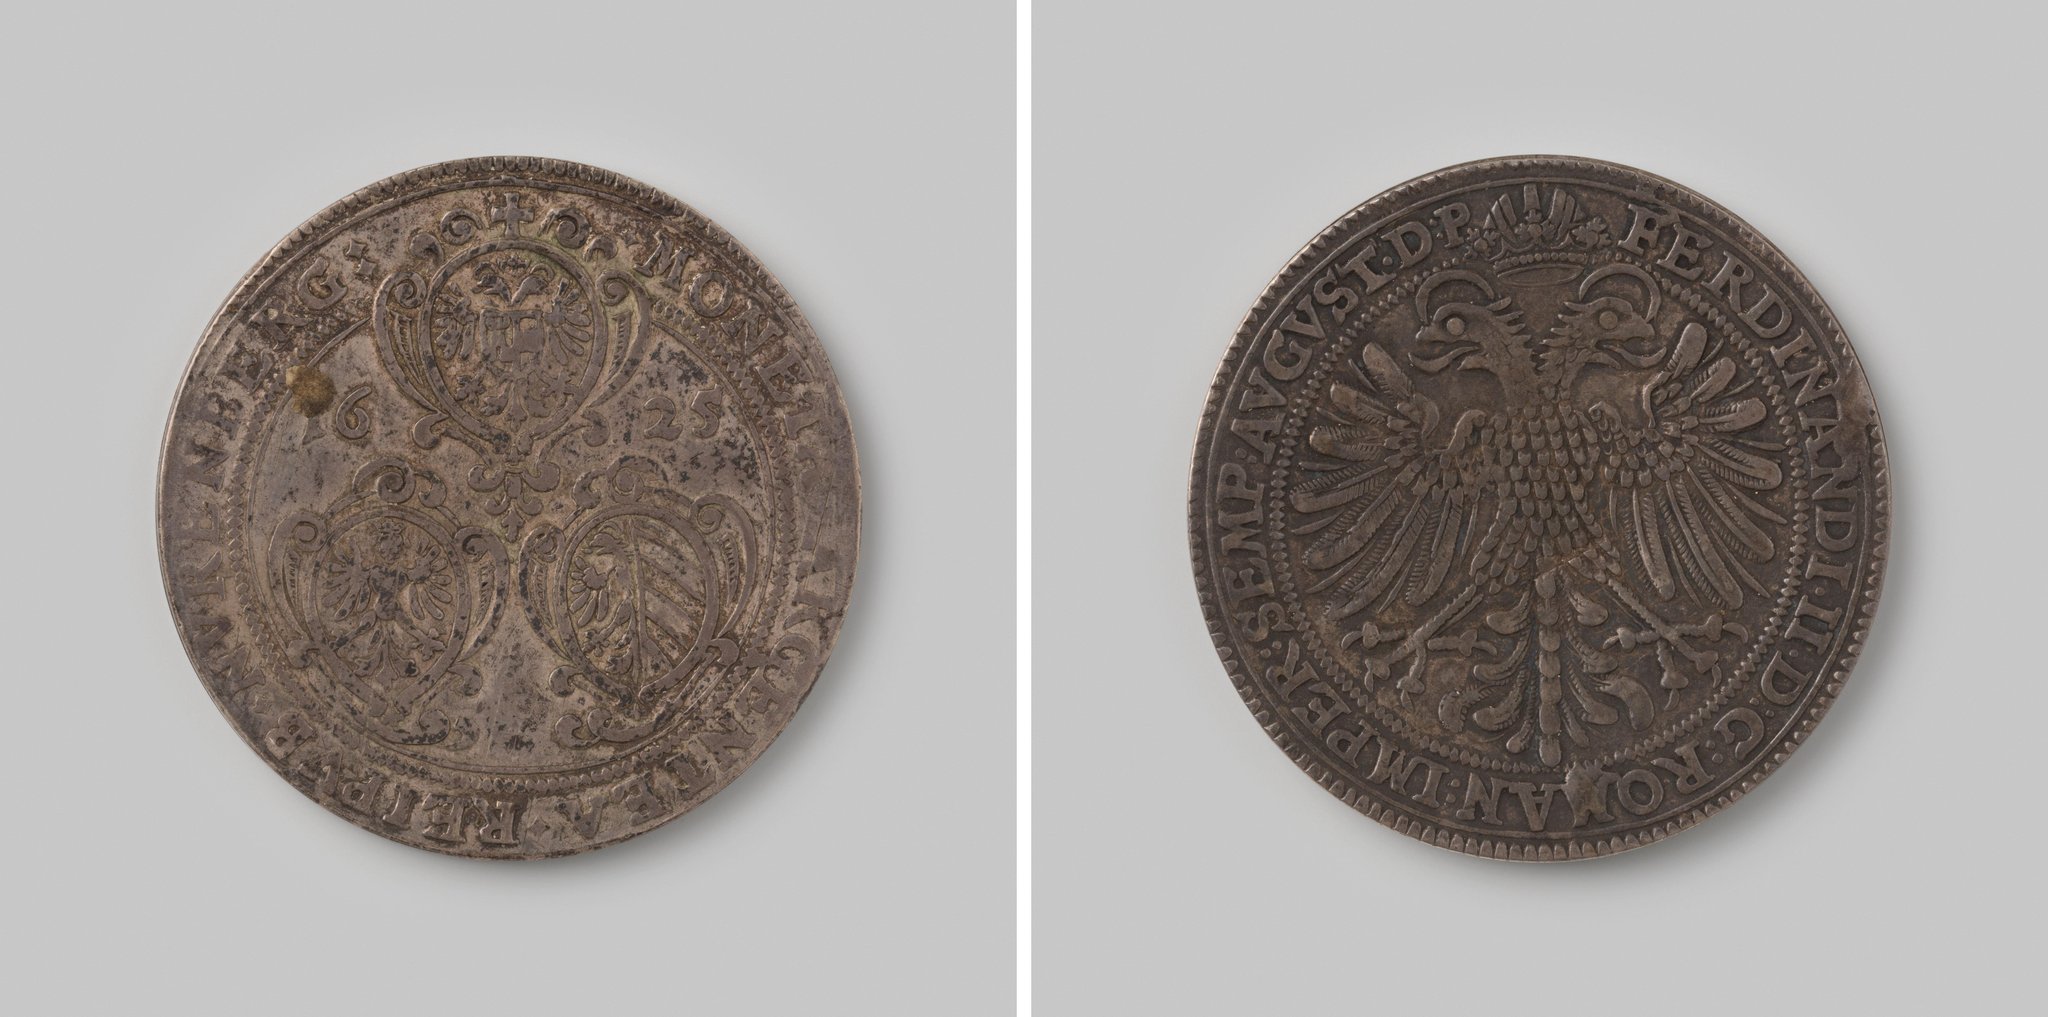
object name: coin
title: Rijksstad Neurenberg, keizer Ferdinand II, schroeftaler, 1625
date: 1625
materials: silver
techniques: striking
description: Zilveren bewerkte munt, muntplaatje uitgehold en van schroefdraad voorzien. Voorzijde: onder en boven jaartal drie wapenschilden. Keerzijde: gekroonde dubbelkoppige adelaar. Gladde rand. In uitholling plaatjes?